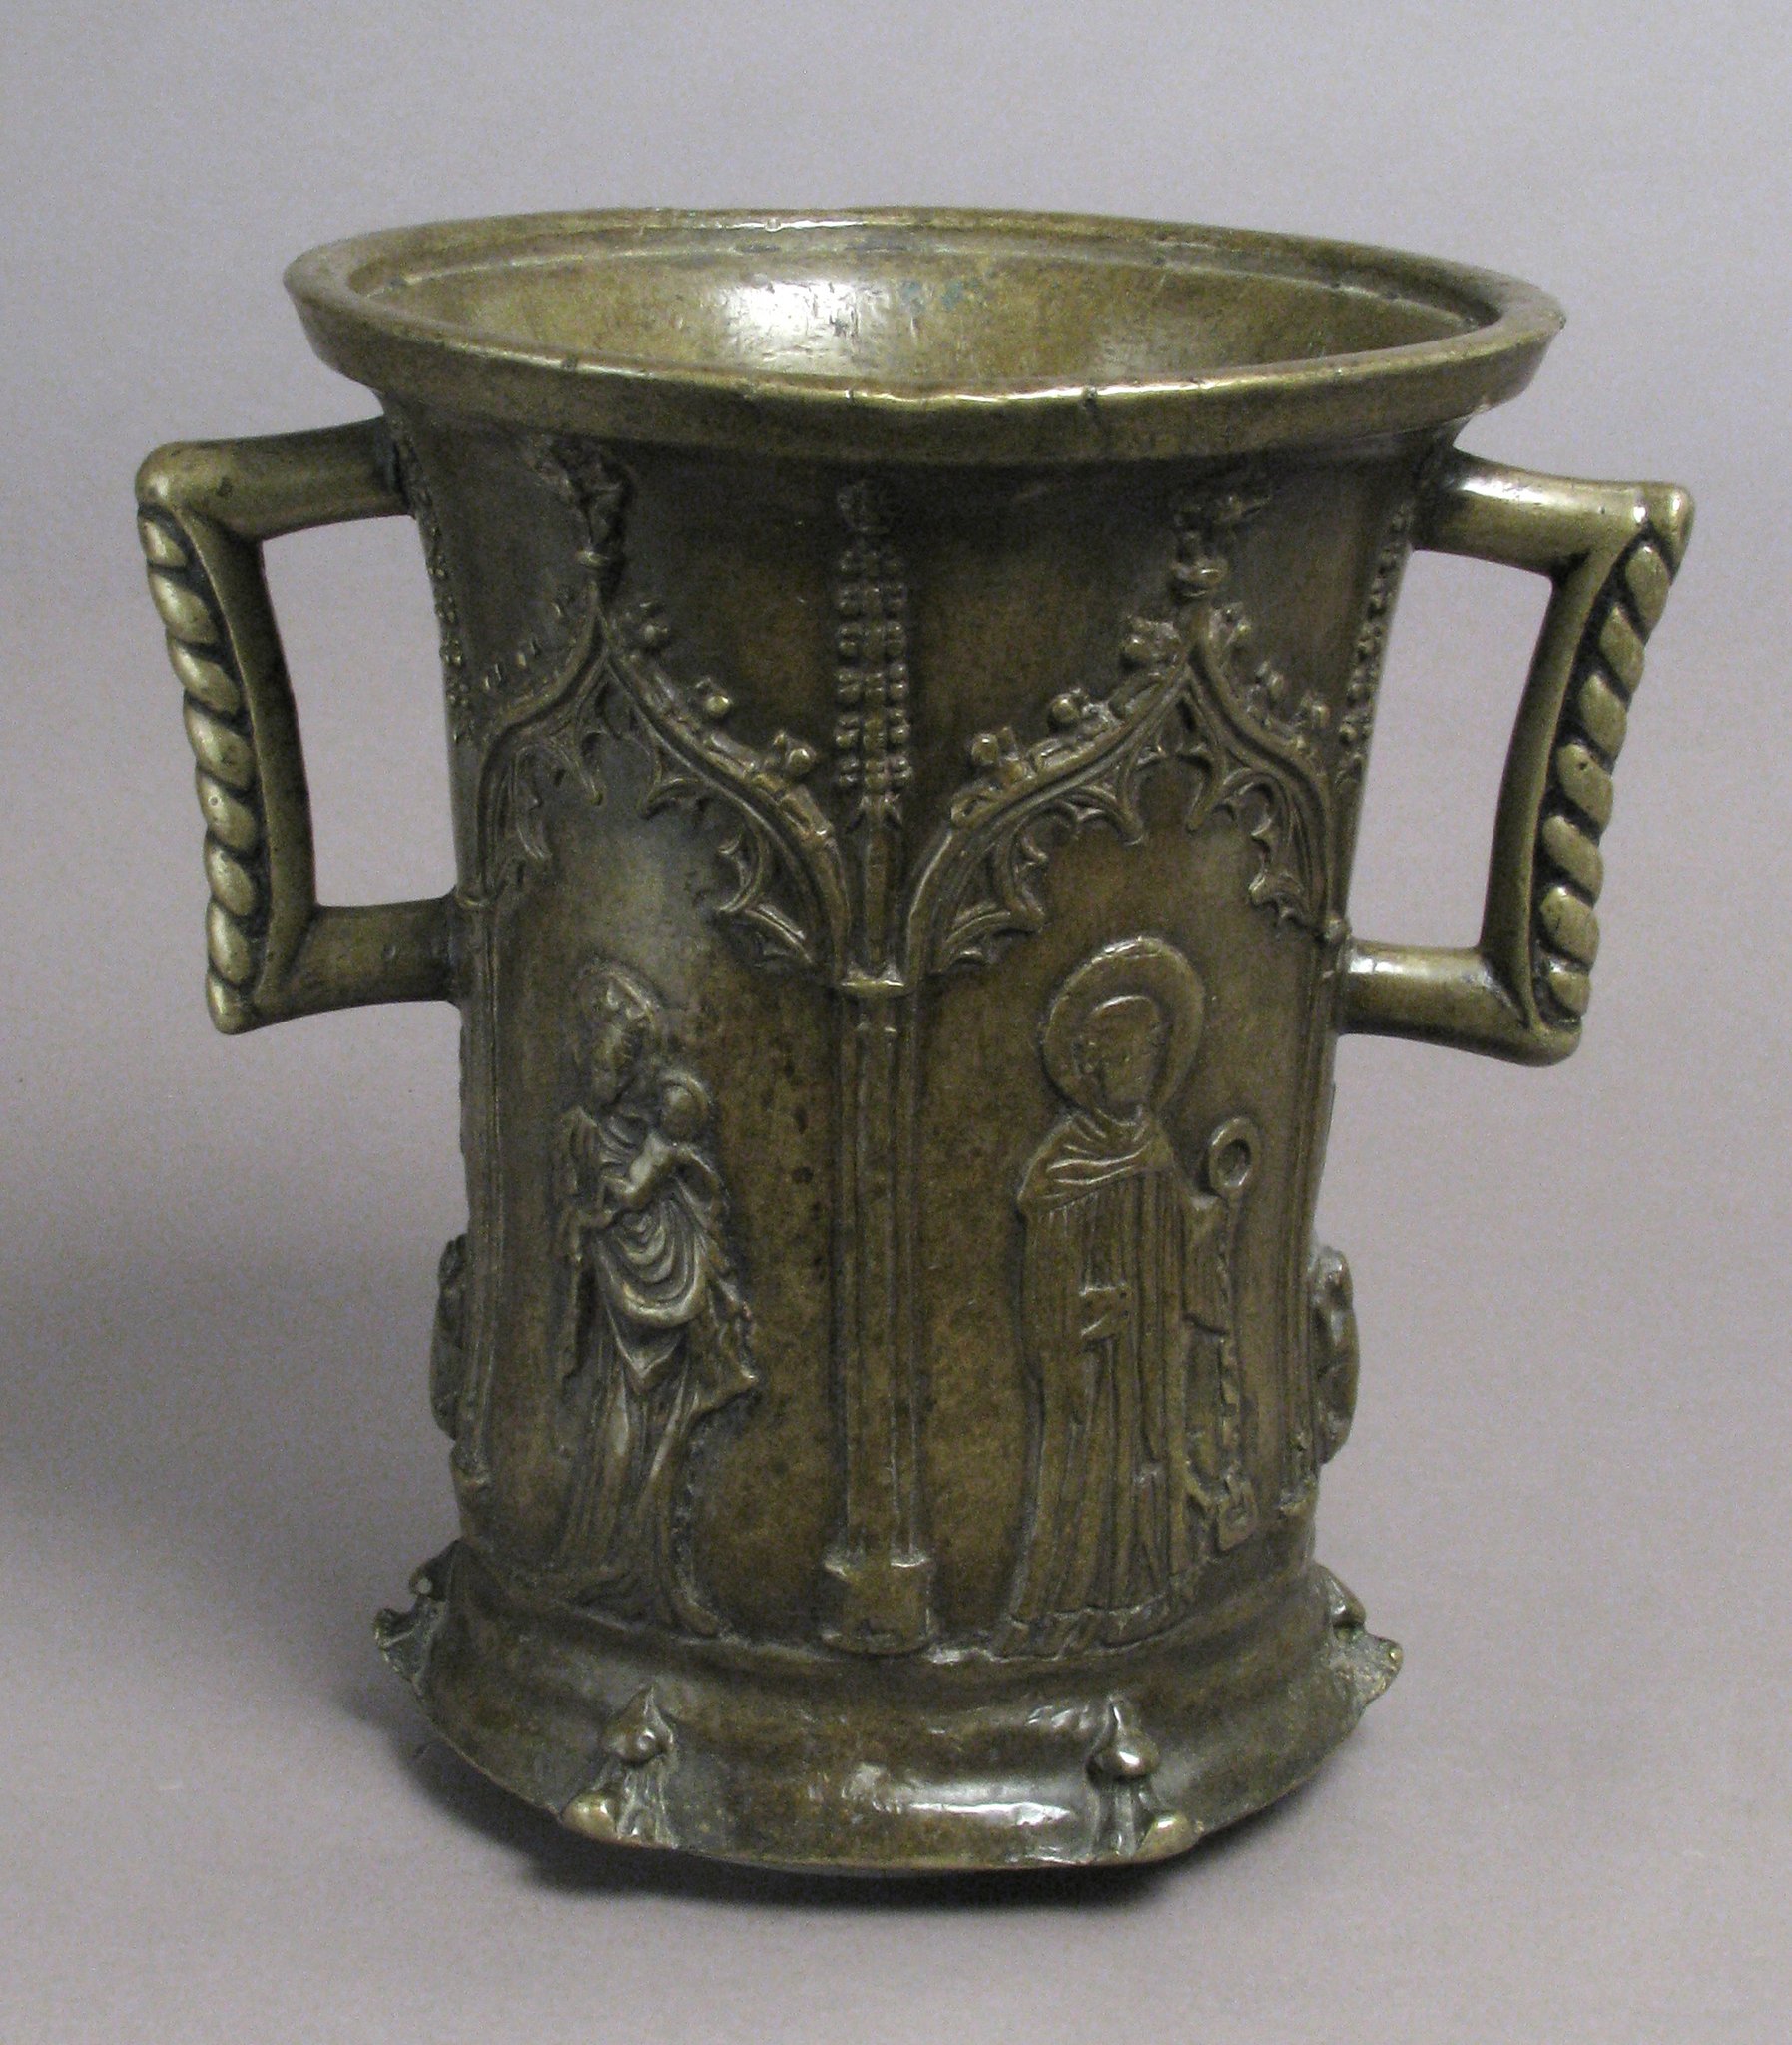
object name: mortar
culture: austrian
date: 1451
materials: brass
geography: austria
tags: men,madonna and child,saints